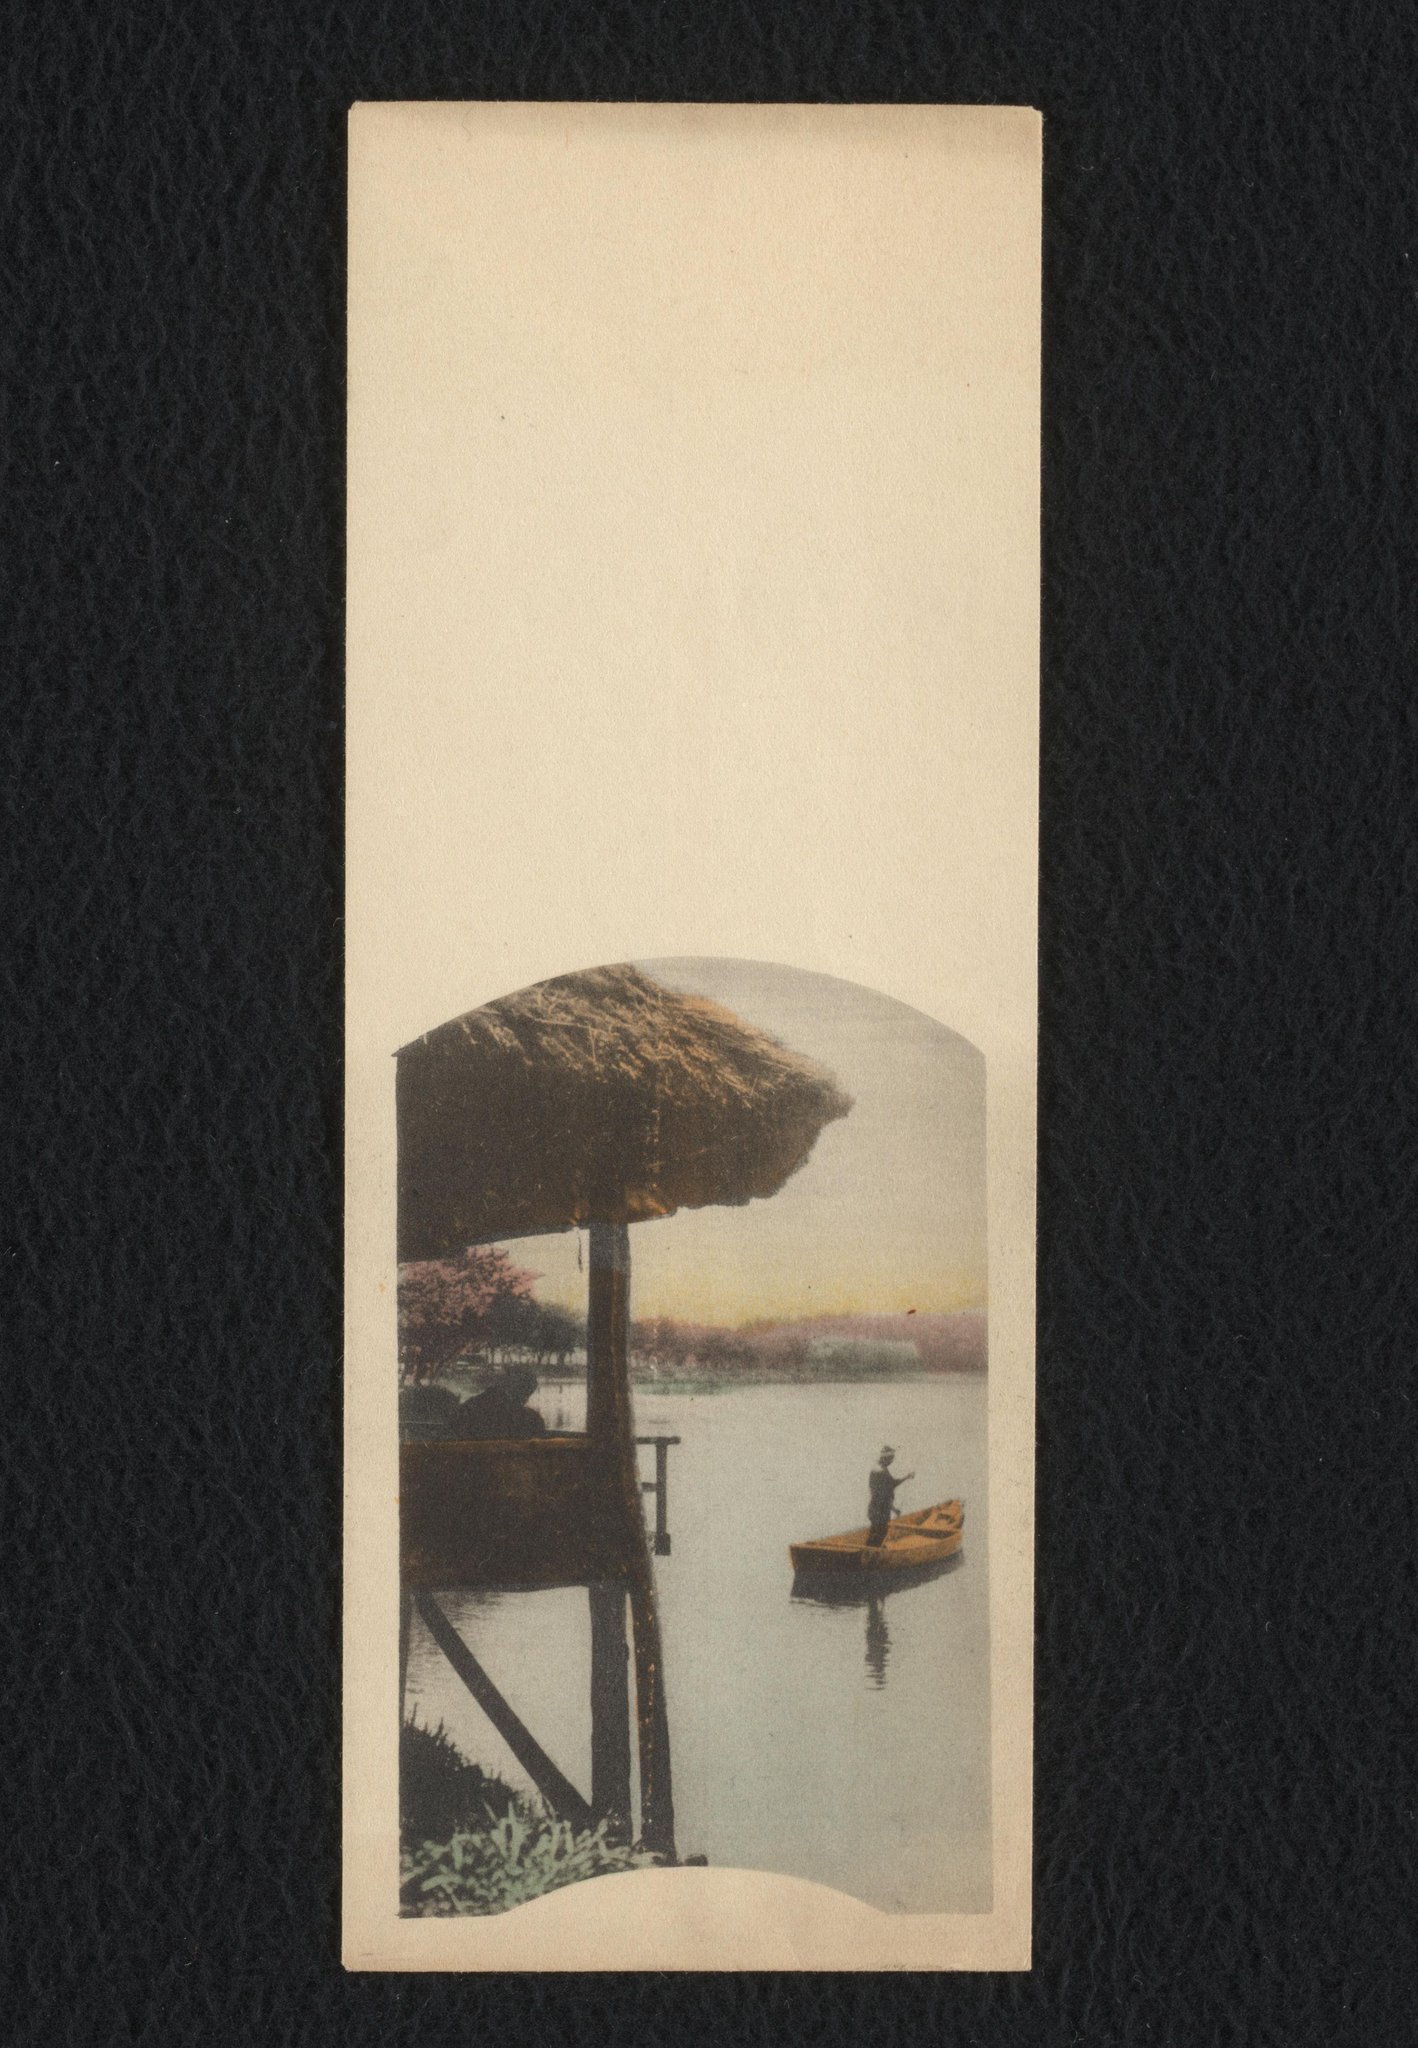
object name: photomechanical print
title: Vissende man in een boot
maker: Anonymous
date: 1890-1920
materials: paper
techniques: photograph, lithograph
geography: japan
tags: fisherman, japan